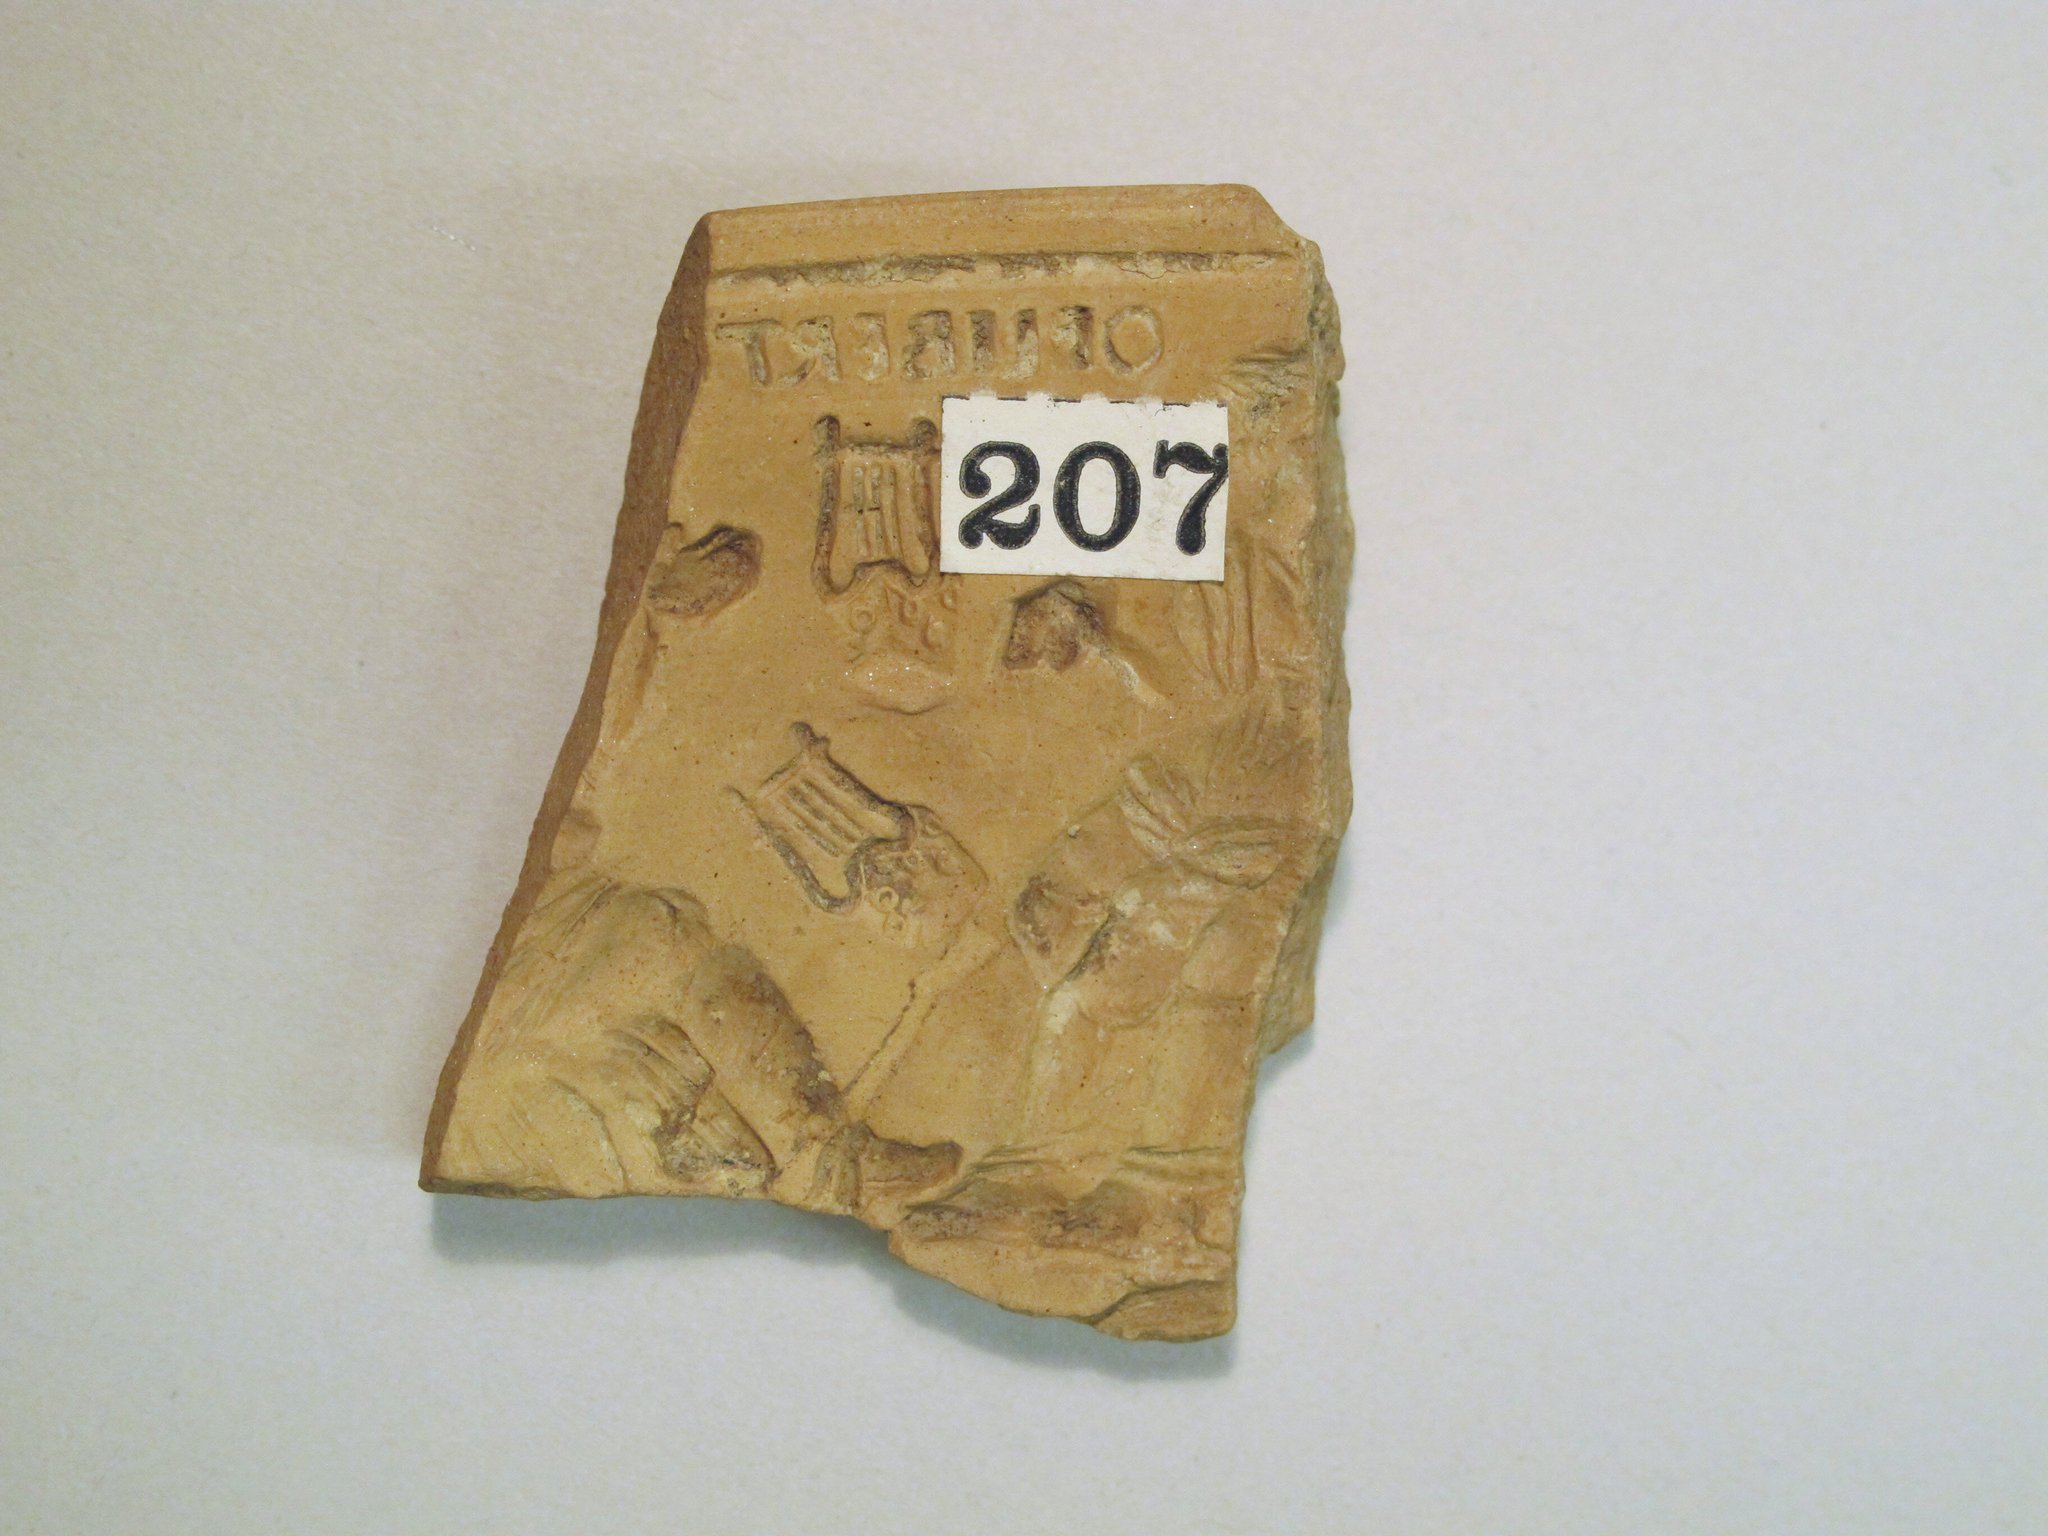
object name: vase fragment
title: Terracotta mold fragment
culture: roman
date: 101-200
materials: terracotta